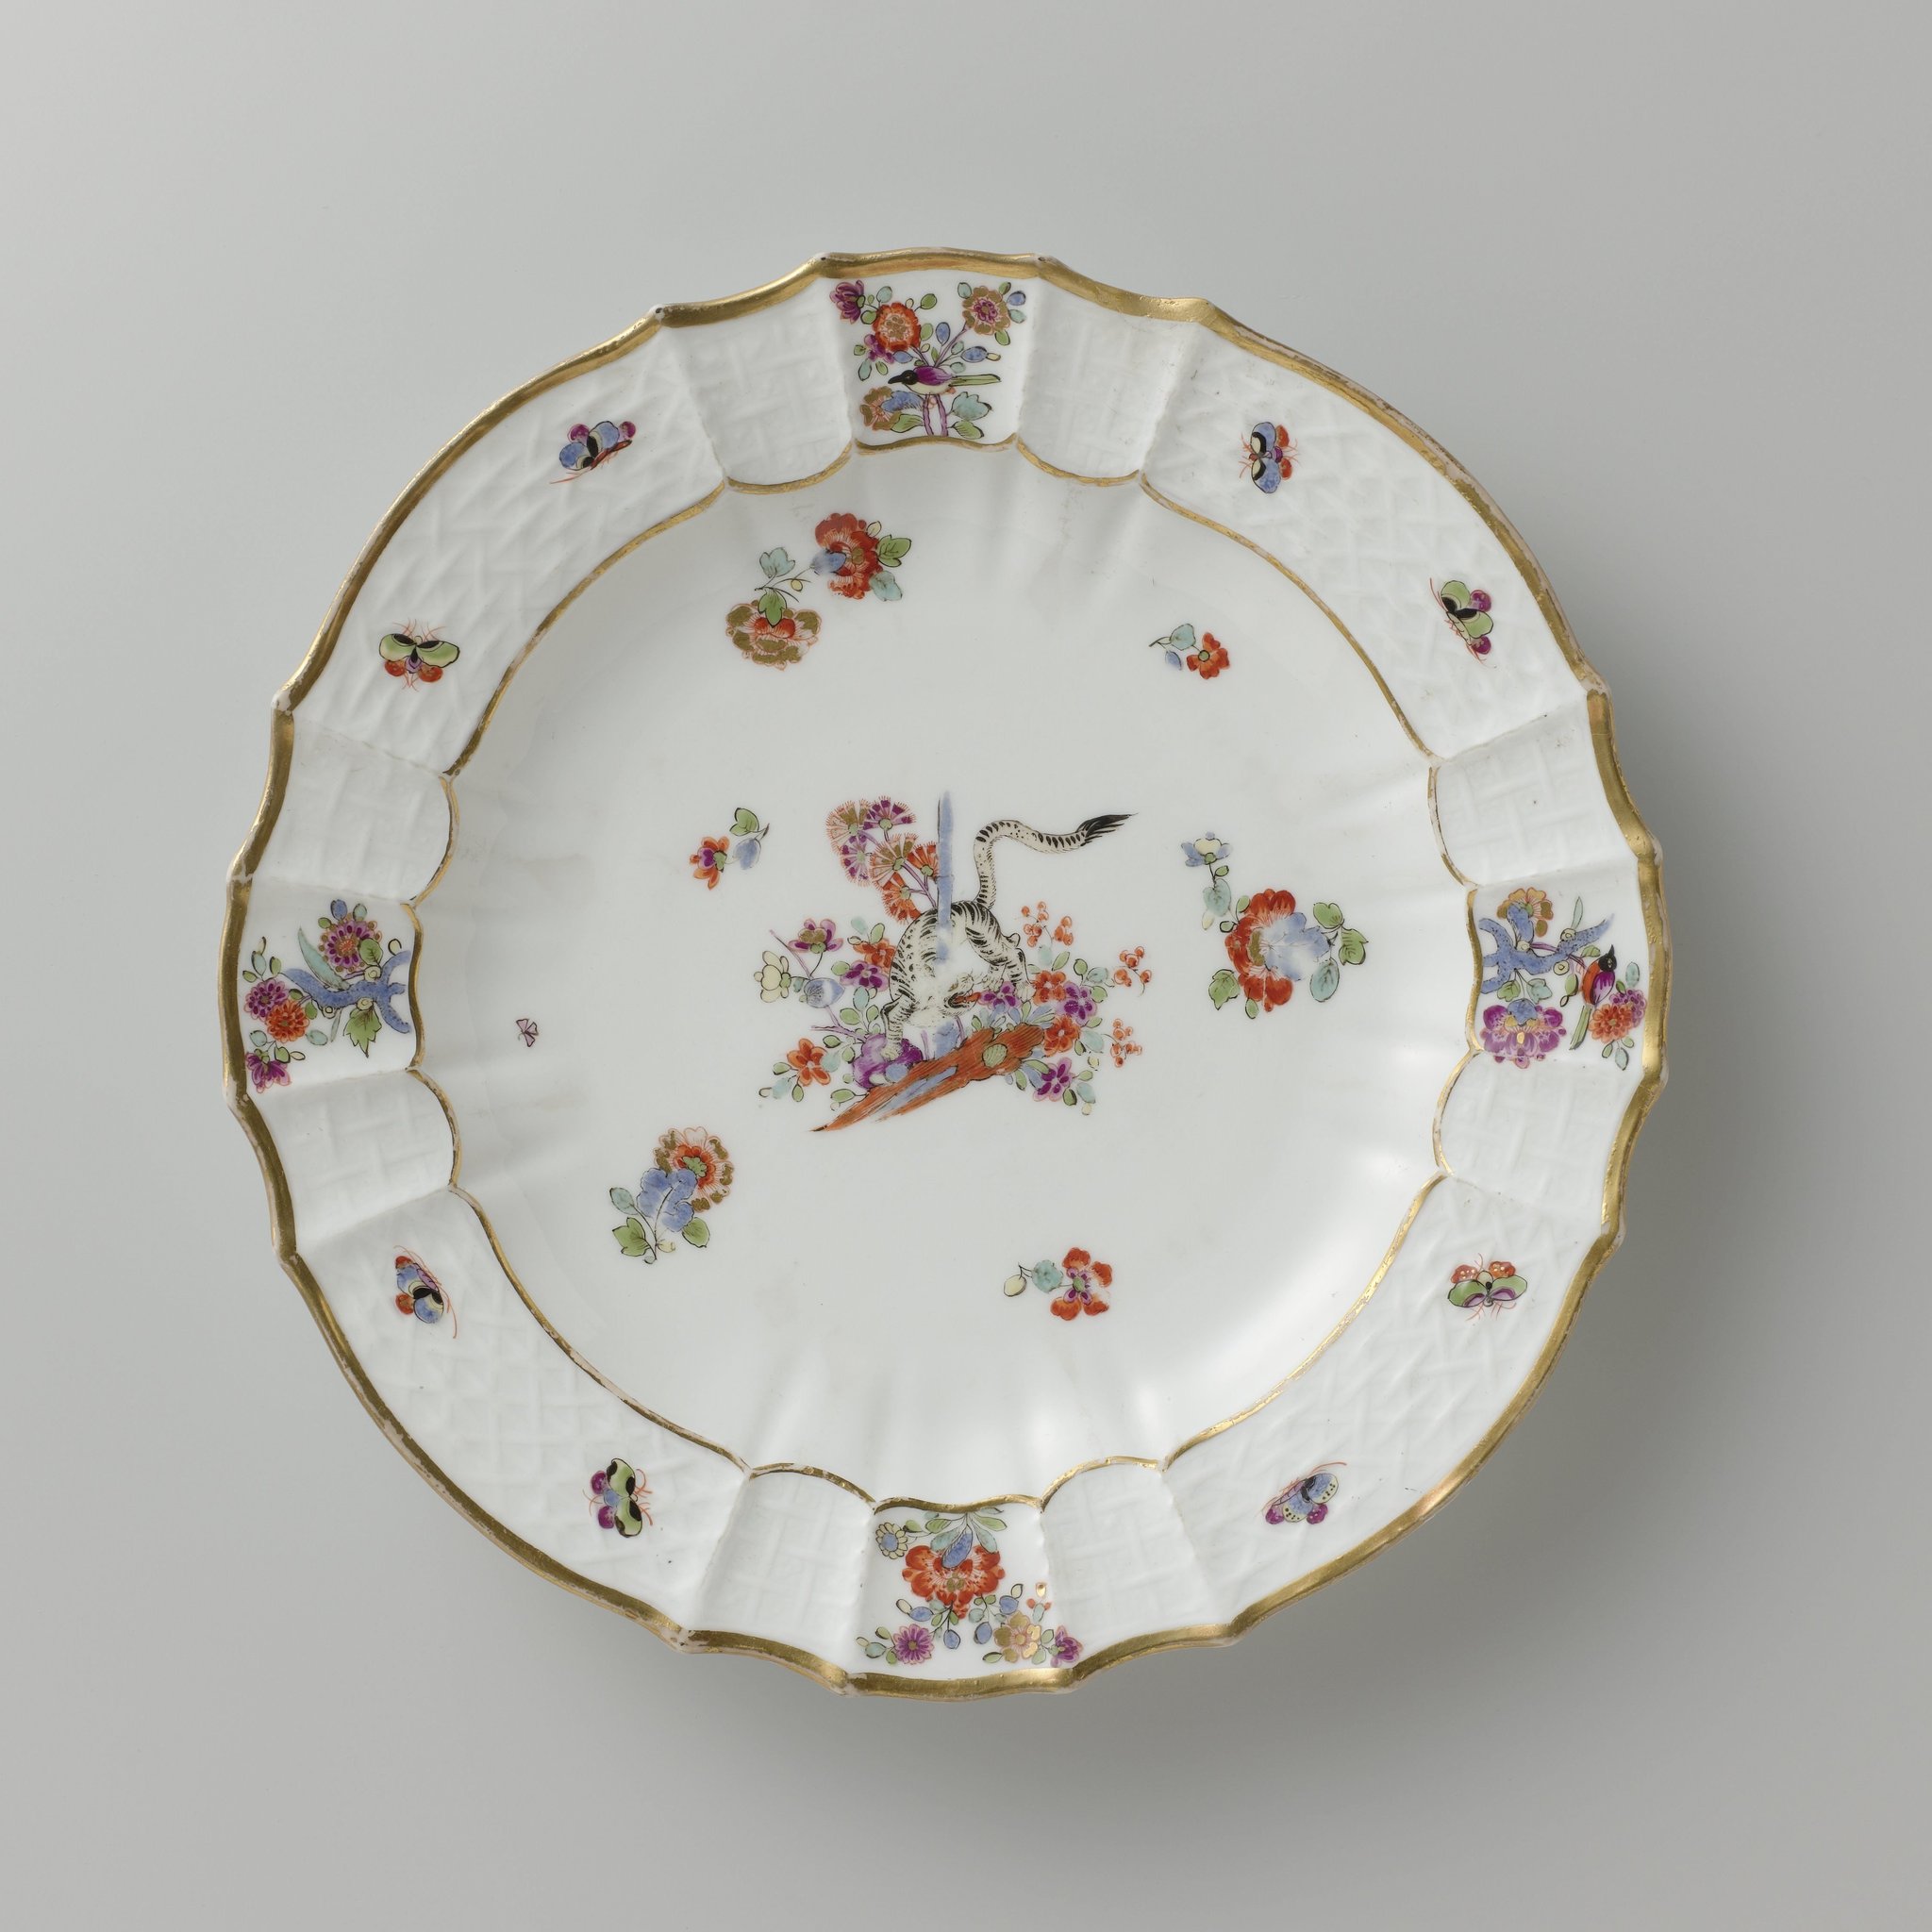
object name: eating drinking utensil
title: Rond bord, veelkleurig beschilderd met een Kakiemon-decor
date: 1740-1745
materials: porcelain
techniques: painted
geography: meissen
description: Rond bord van beschilderd porselein. Het bord is geribd en heeft een geschulpte rand. Het bord is beschilderd met een tijger die om een blauwe bamboestengel tussen bloemen is gedraaid, gestrooide Indianische Blumen, vlinders en takken waarop vogels. De rand is versierd met het 'Altbrandenstein'-patroon. Het bord is gemerkt.